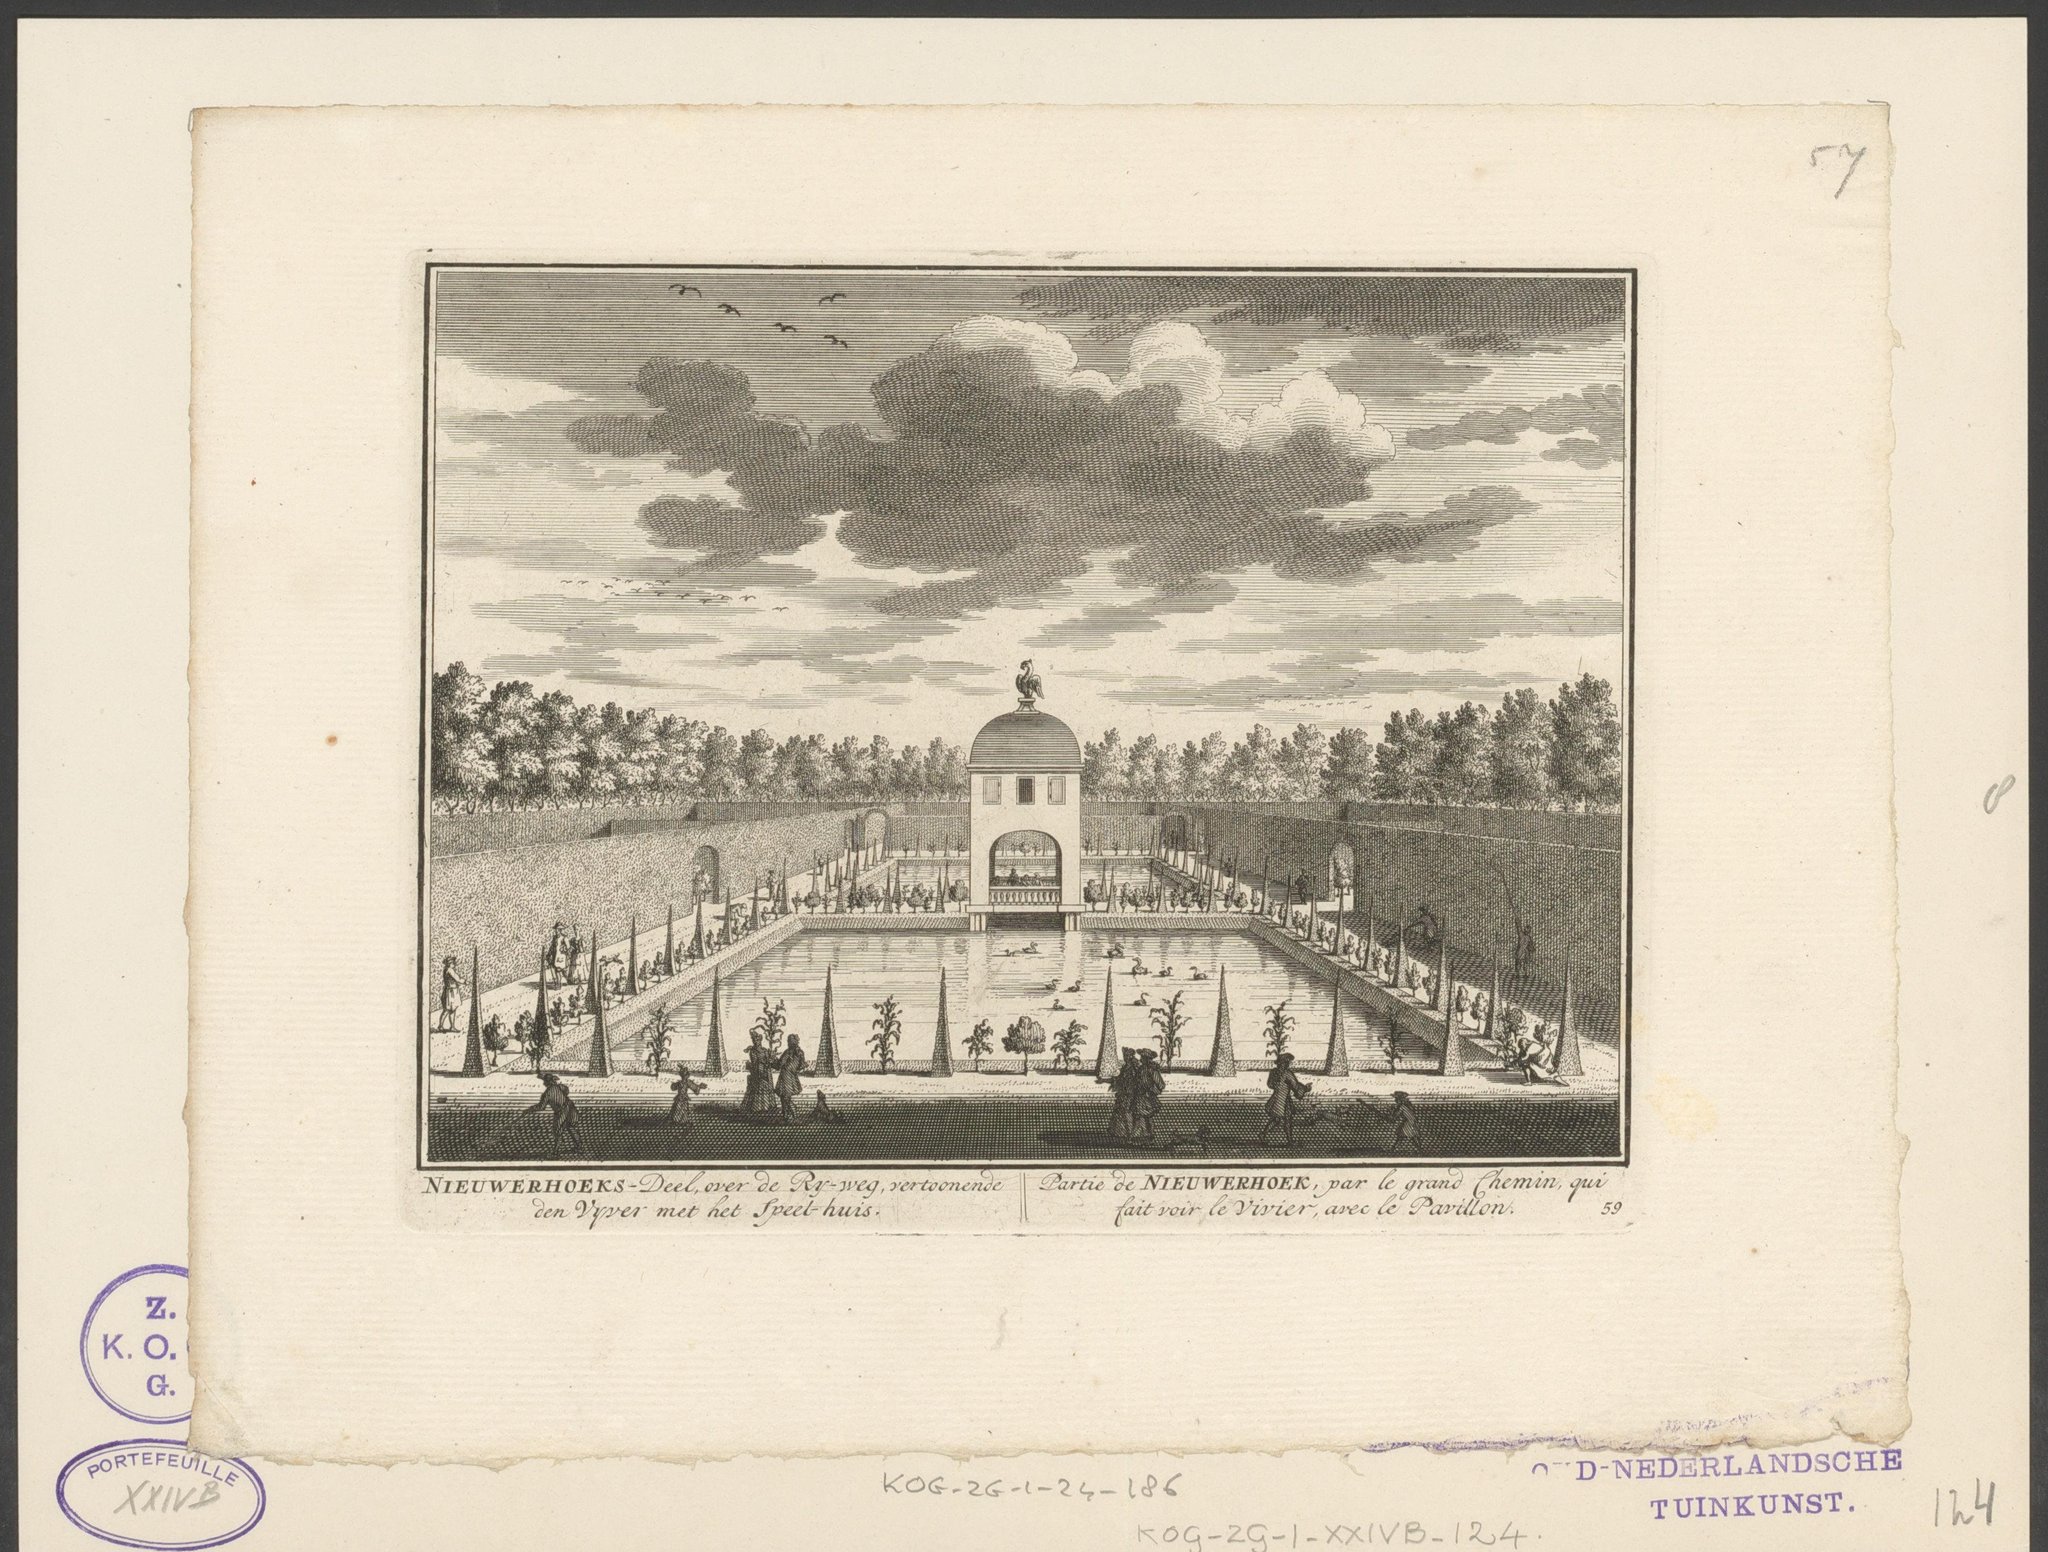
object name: print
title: Nieuwerhoeks-Deel, over de Rijweg, vertoonende den Vijver met het Speel-huis / Partie de Nieuwerhoek, par le grand Chemin, qui fait voir le Vivier, avec le Pavillon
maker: hendrik de leth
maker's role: draughtsman, print maker, publisher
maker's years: 1703-1766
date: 1729-1732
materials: paper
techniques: engraving, etching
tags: french or architectonic garden; formal garden, garden pond, country-house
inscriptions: stamp, stamp, collector's mark: Lugt 1641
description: Prent mogelijk uit: Brouërius van Nidek, Matthaeus. Het zegepralend Kennemerland, vertoond in 100 heerlyke gezichten. Amsterdam: Jan Roman, s.a. Of uit: Brouërius van Nidek, Matthaeus. Het zegepralend Kennemerland, vertoond in veele heerlyke gezichten. Amsterdam: Andries en Hendrik de Leth, s.a [1729-1732]. Of uit: Brouërius van Nidek, Matthaeus. Het zegepralend Kennemerland, vertoond in veele heerlyke gezichten. Amsterdam: Jan Roman, s.a.